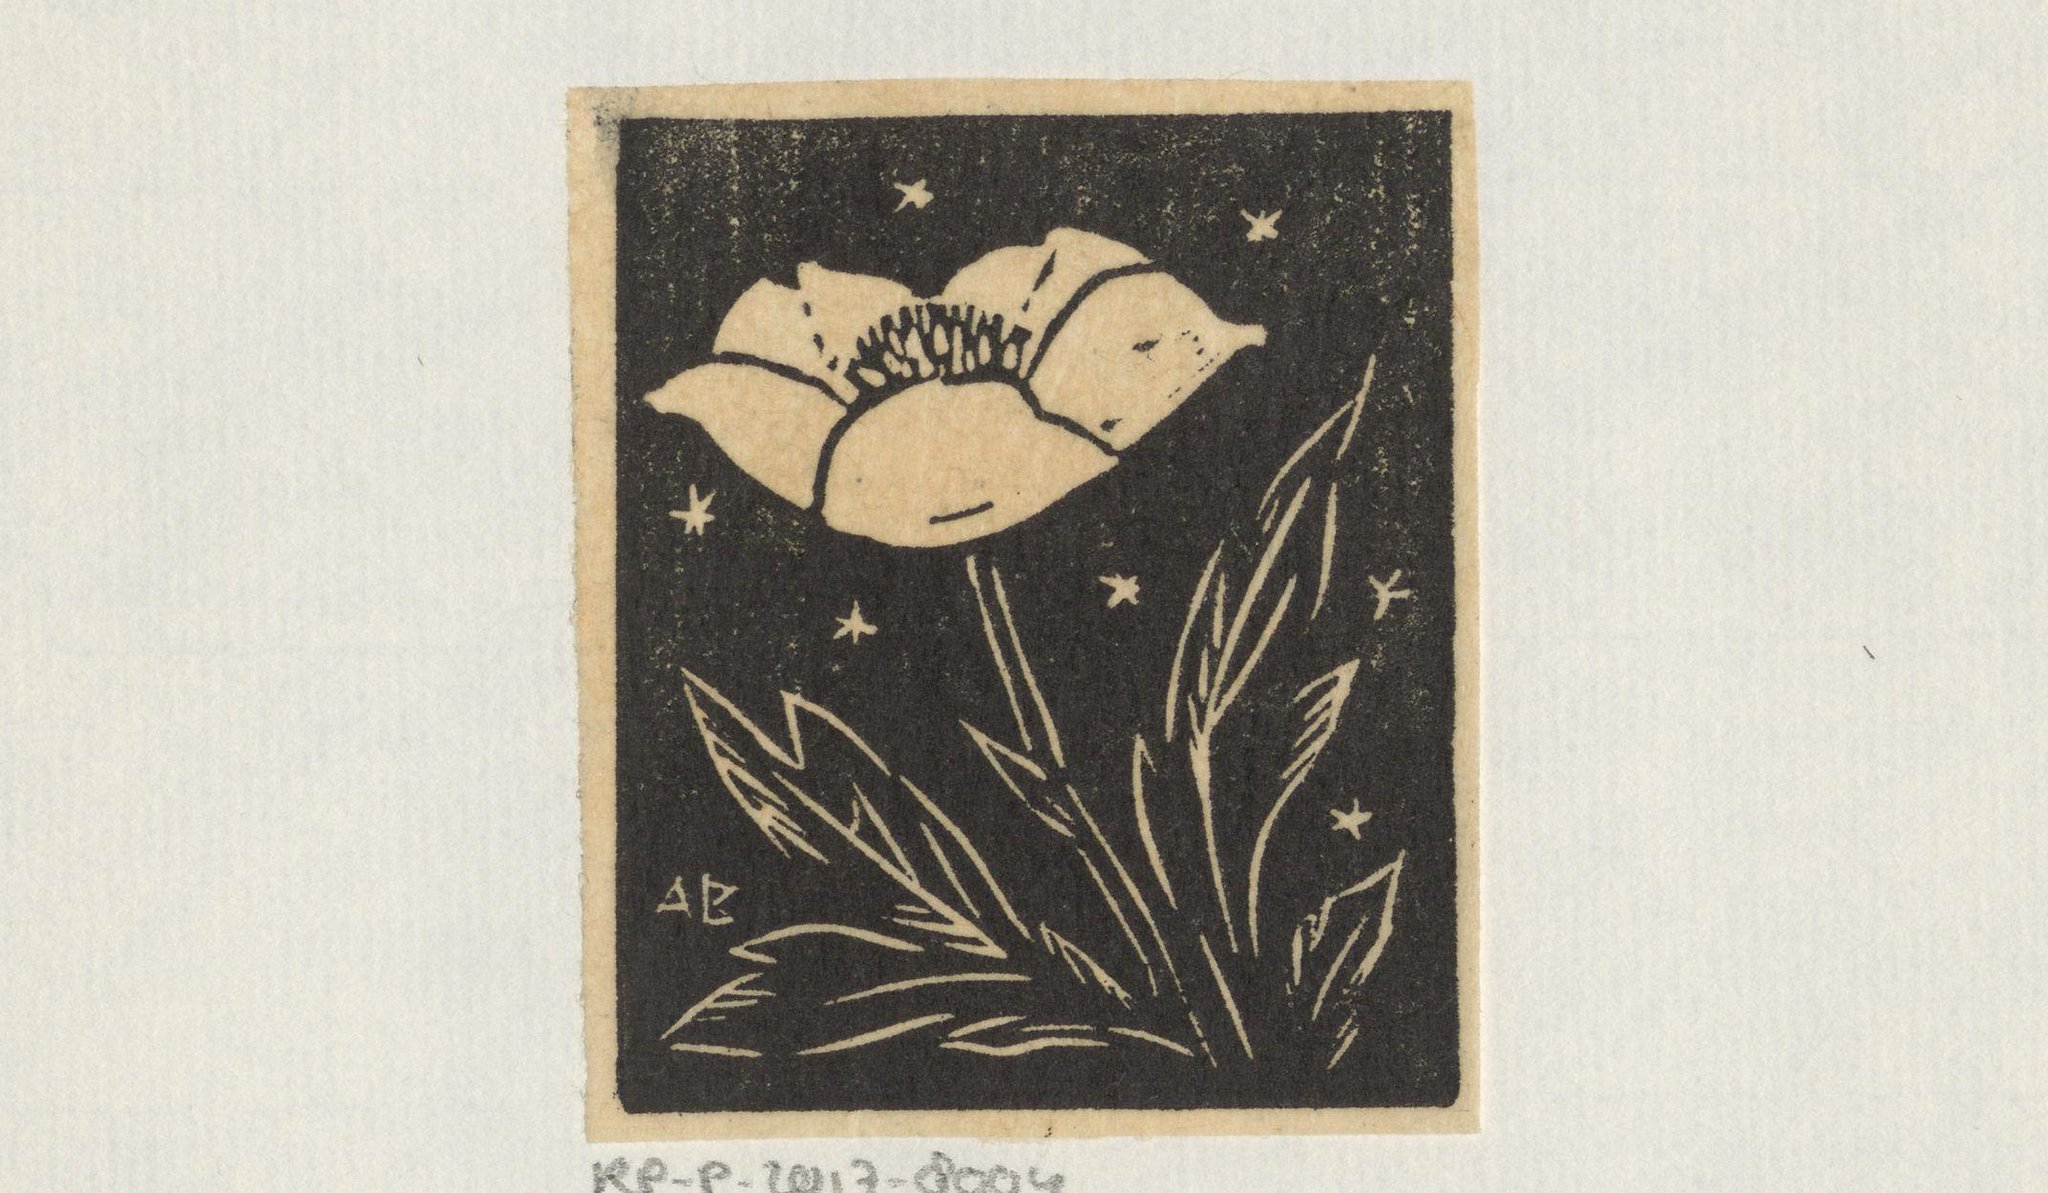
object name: bookplate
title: Ex libris van A.B.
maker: Anonymous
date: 1900-1999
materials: paper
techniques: woodcut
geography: spain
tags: plants and herbs